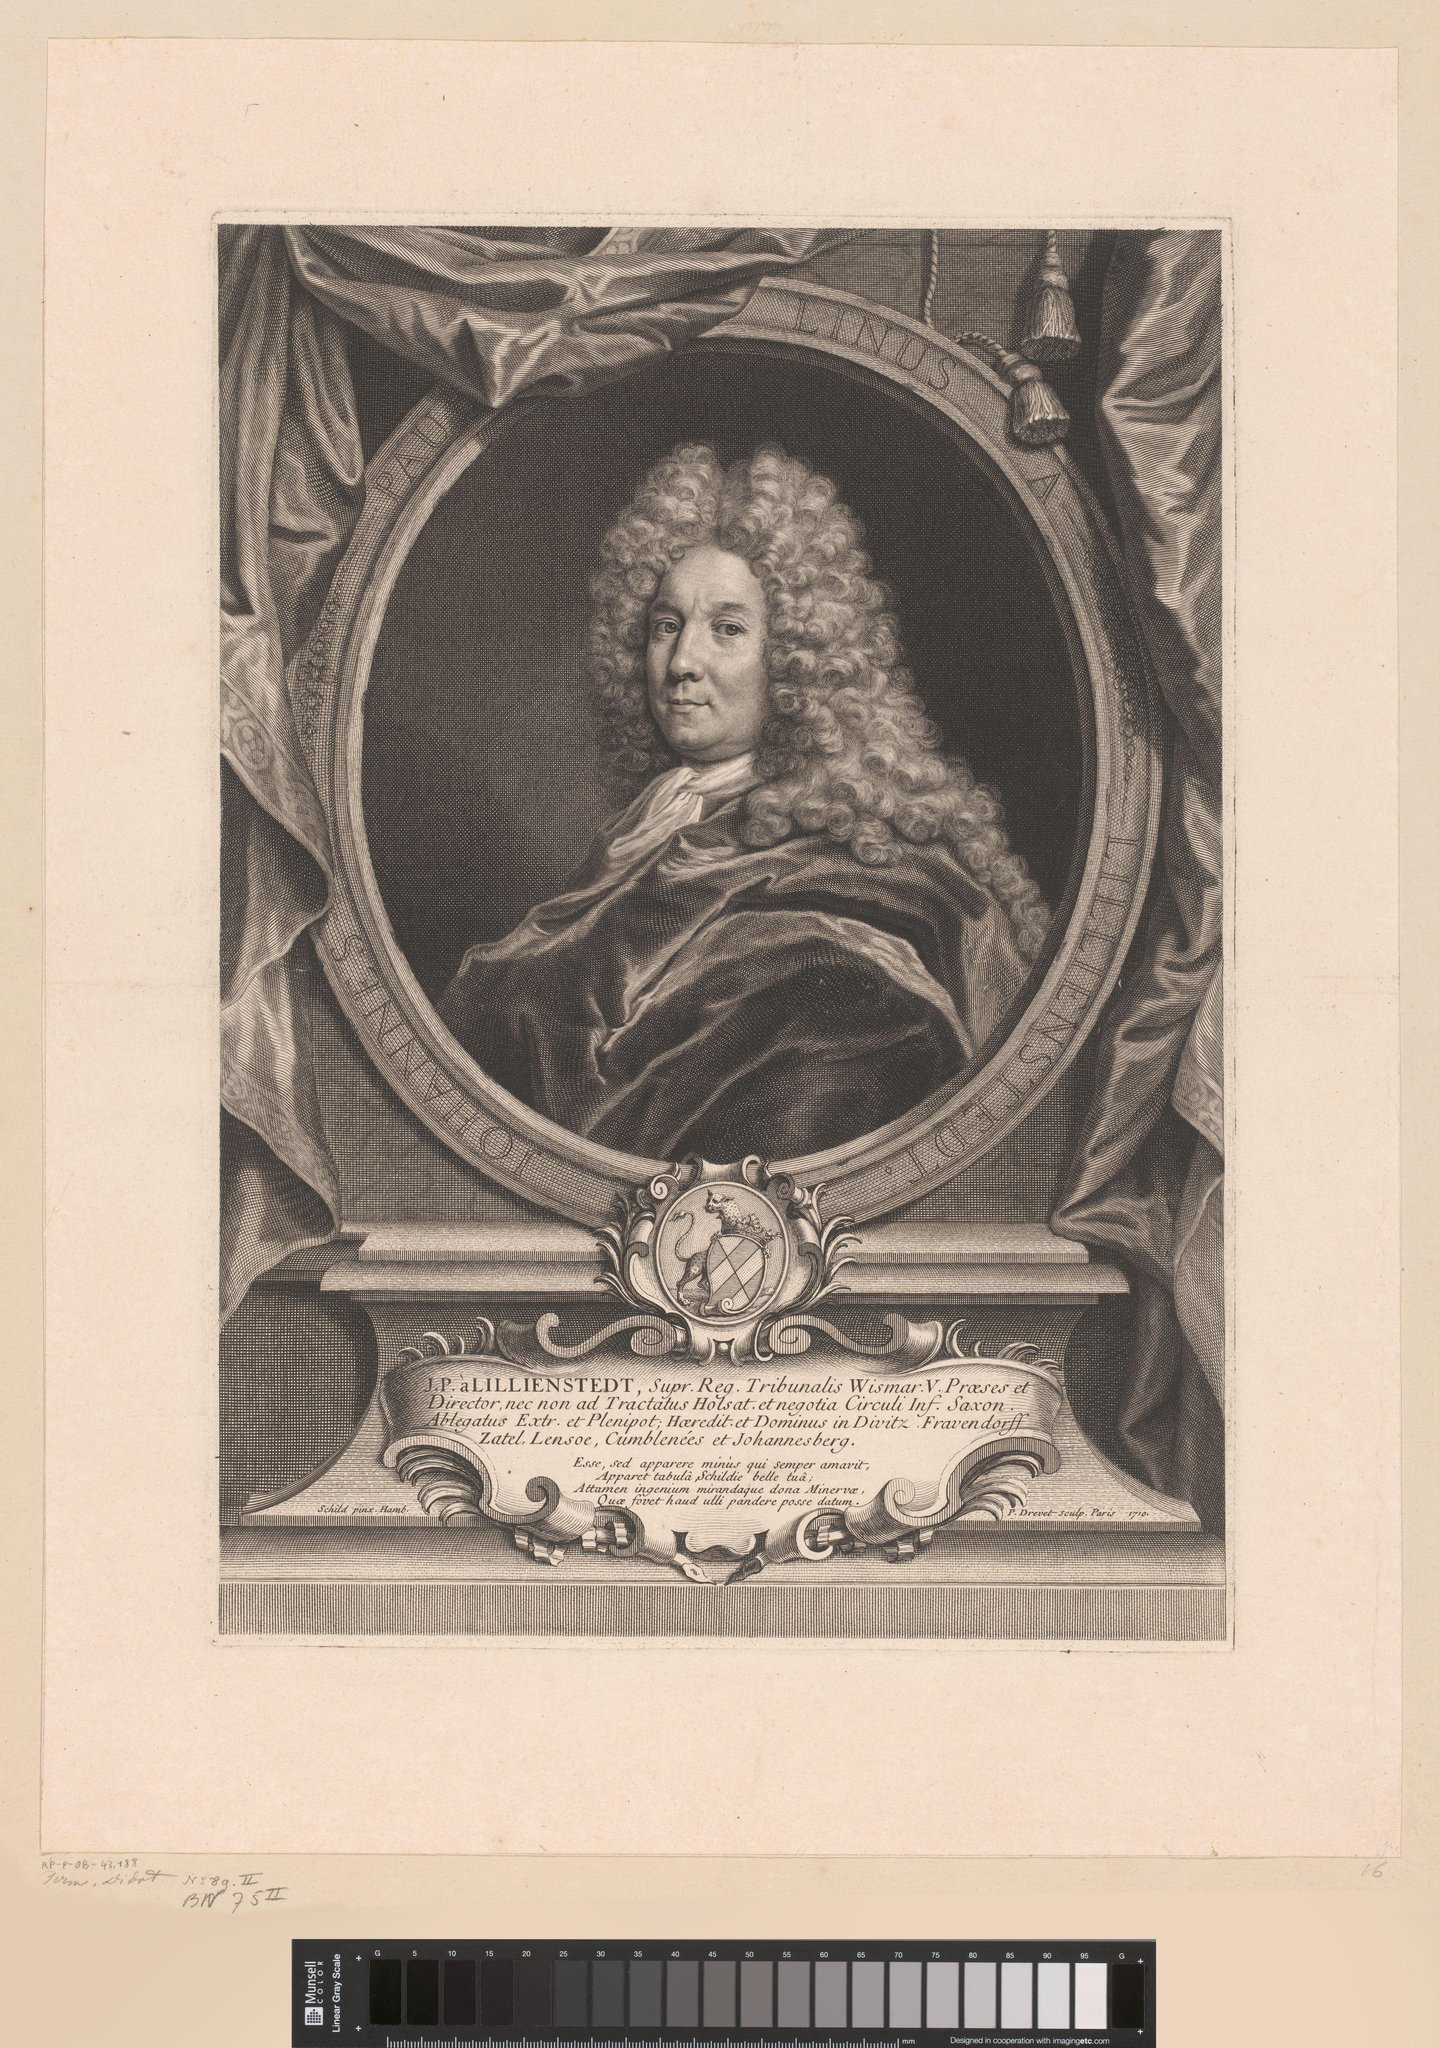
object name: print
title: J.P. à Lillienstedt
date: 1710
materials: paper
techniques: engraving, etching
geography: paris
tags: earl, ornament ~ medallion, historical persons, armorial bearing, heraldry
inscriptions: collector's mark: Lugt 240